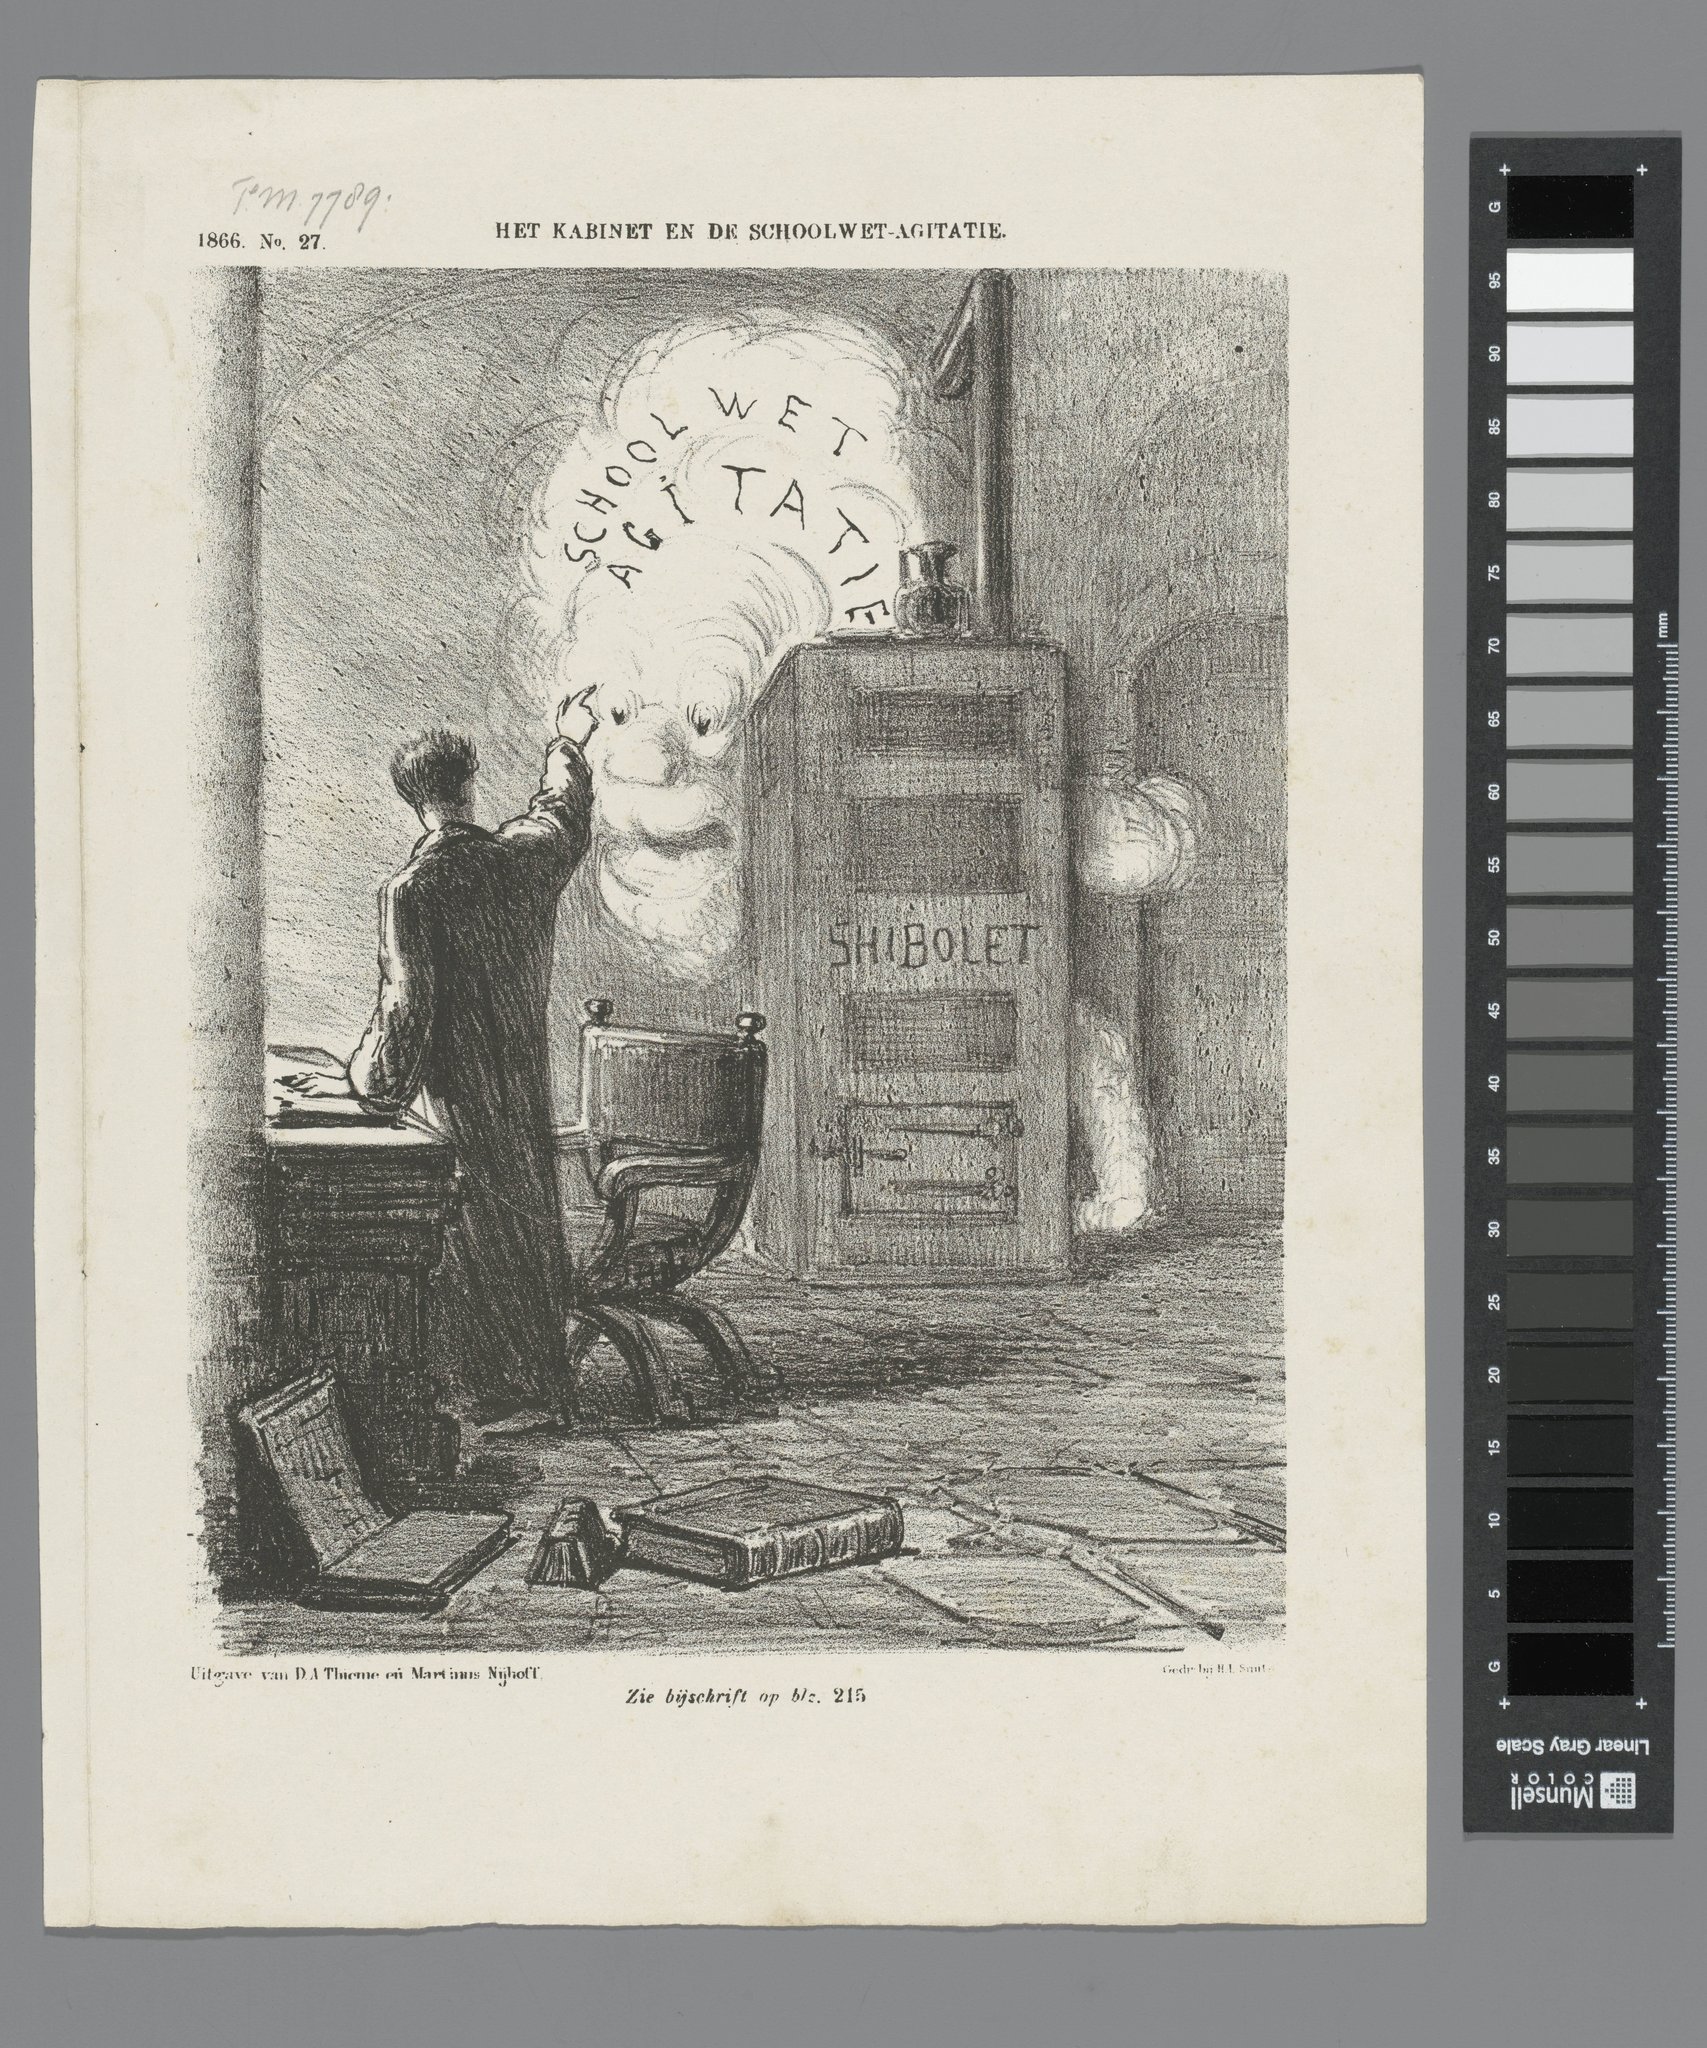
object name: cartoon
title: Spotprent met minister Heemskerk als Faust, 1866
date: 1866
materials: paper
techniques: lithograph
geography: arnhem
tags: faust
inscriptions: collector's mark: Lugt 2228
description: Spotprent waarin minister Heemskerk als Faust de schoolwet-agitatie bezweert. Plaat verschenen bij het weekblad De Nederlandsche Spectator, nr. 27, 7 juli 1866.